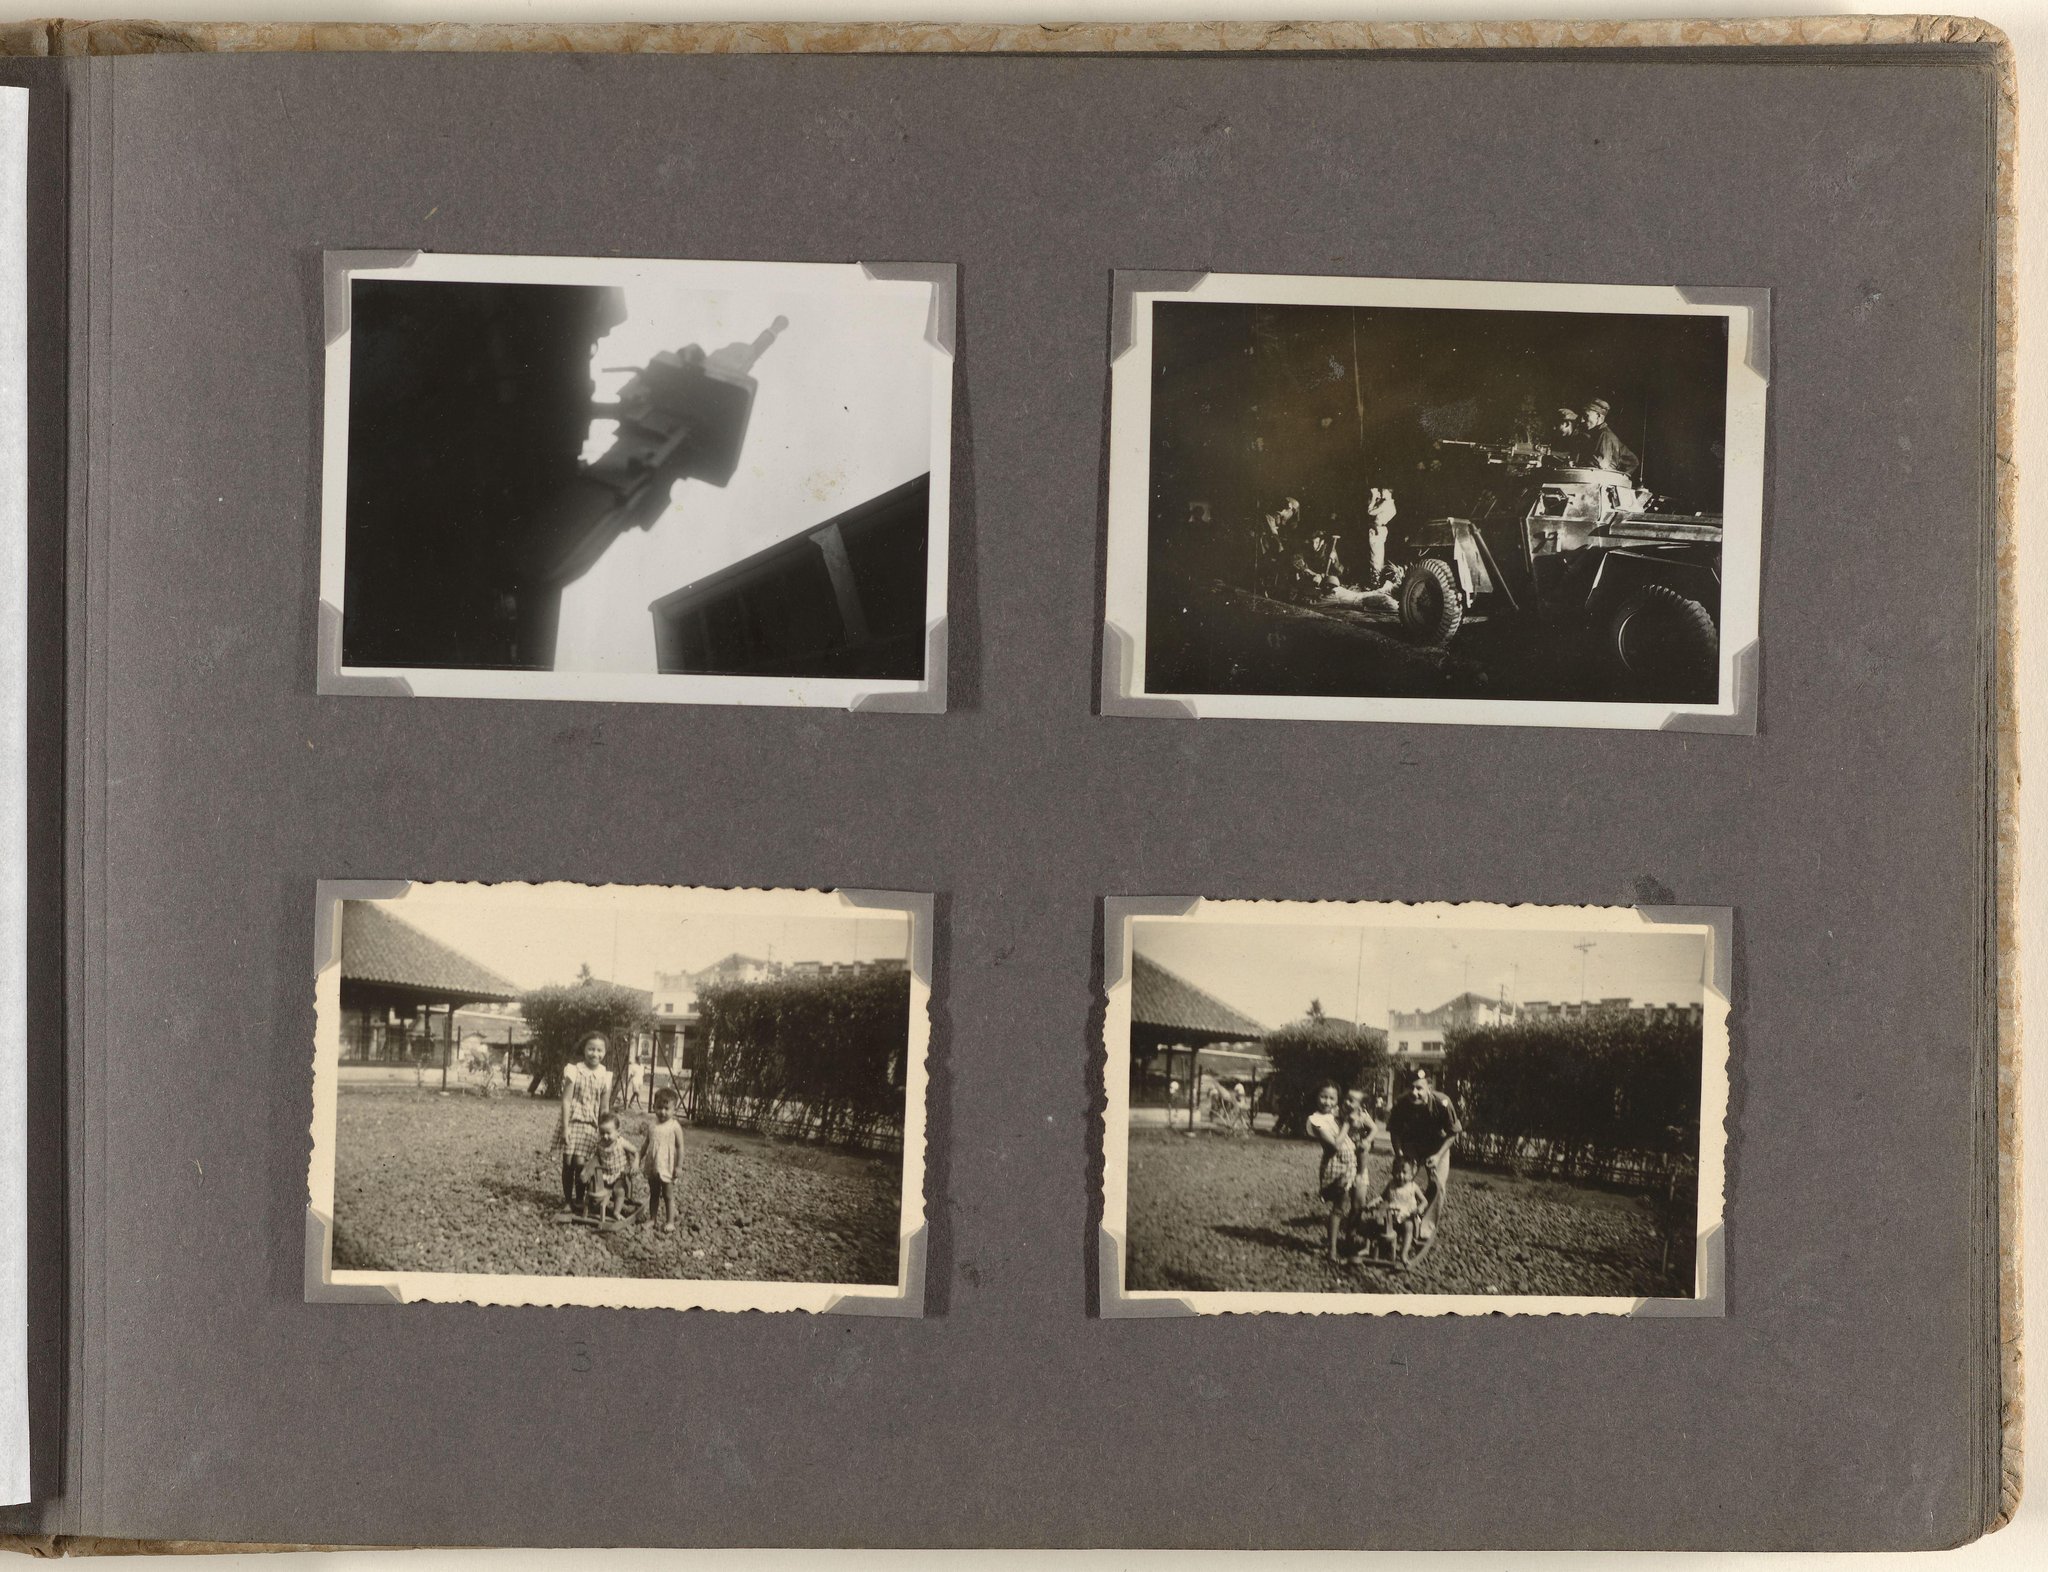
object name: album leaf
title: Diverse onderwerpen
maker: Anonymous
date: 1946-1949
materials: cardboard, photographic support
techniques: gelatin silver print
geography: dutch east indies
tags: colonial system, military service, firearms (with name), dutch east indies, the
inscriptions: inscription: ‘Besa Post / Gombang’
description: Albumblad met vier foto's: stelling met Besa mitrailleur te Gombang, Nederlandse militairen op patrouille en twee foto's van Indonesische kinderen. Onderdeel van het fotoalbum over de diensttijd van Nederlandse militairen in Nederlands-Indië, ca. 1946-1949.